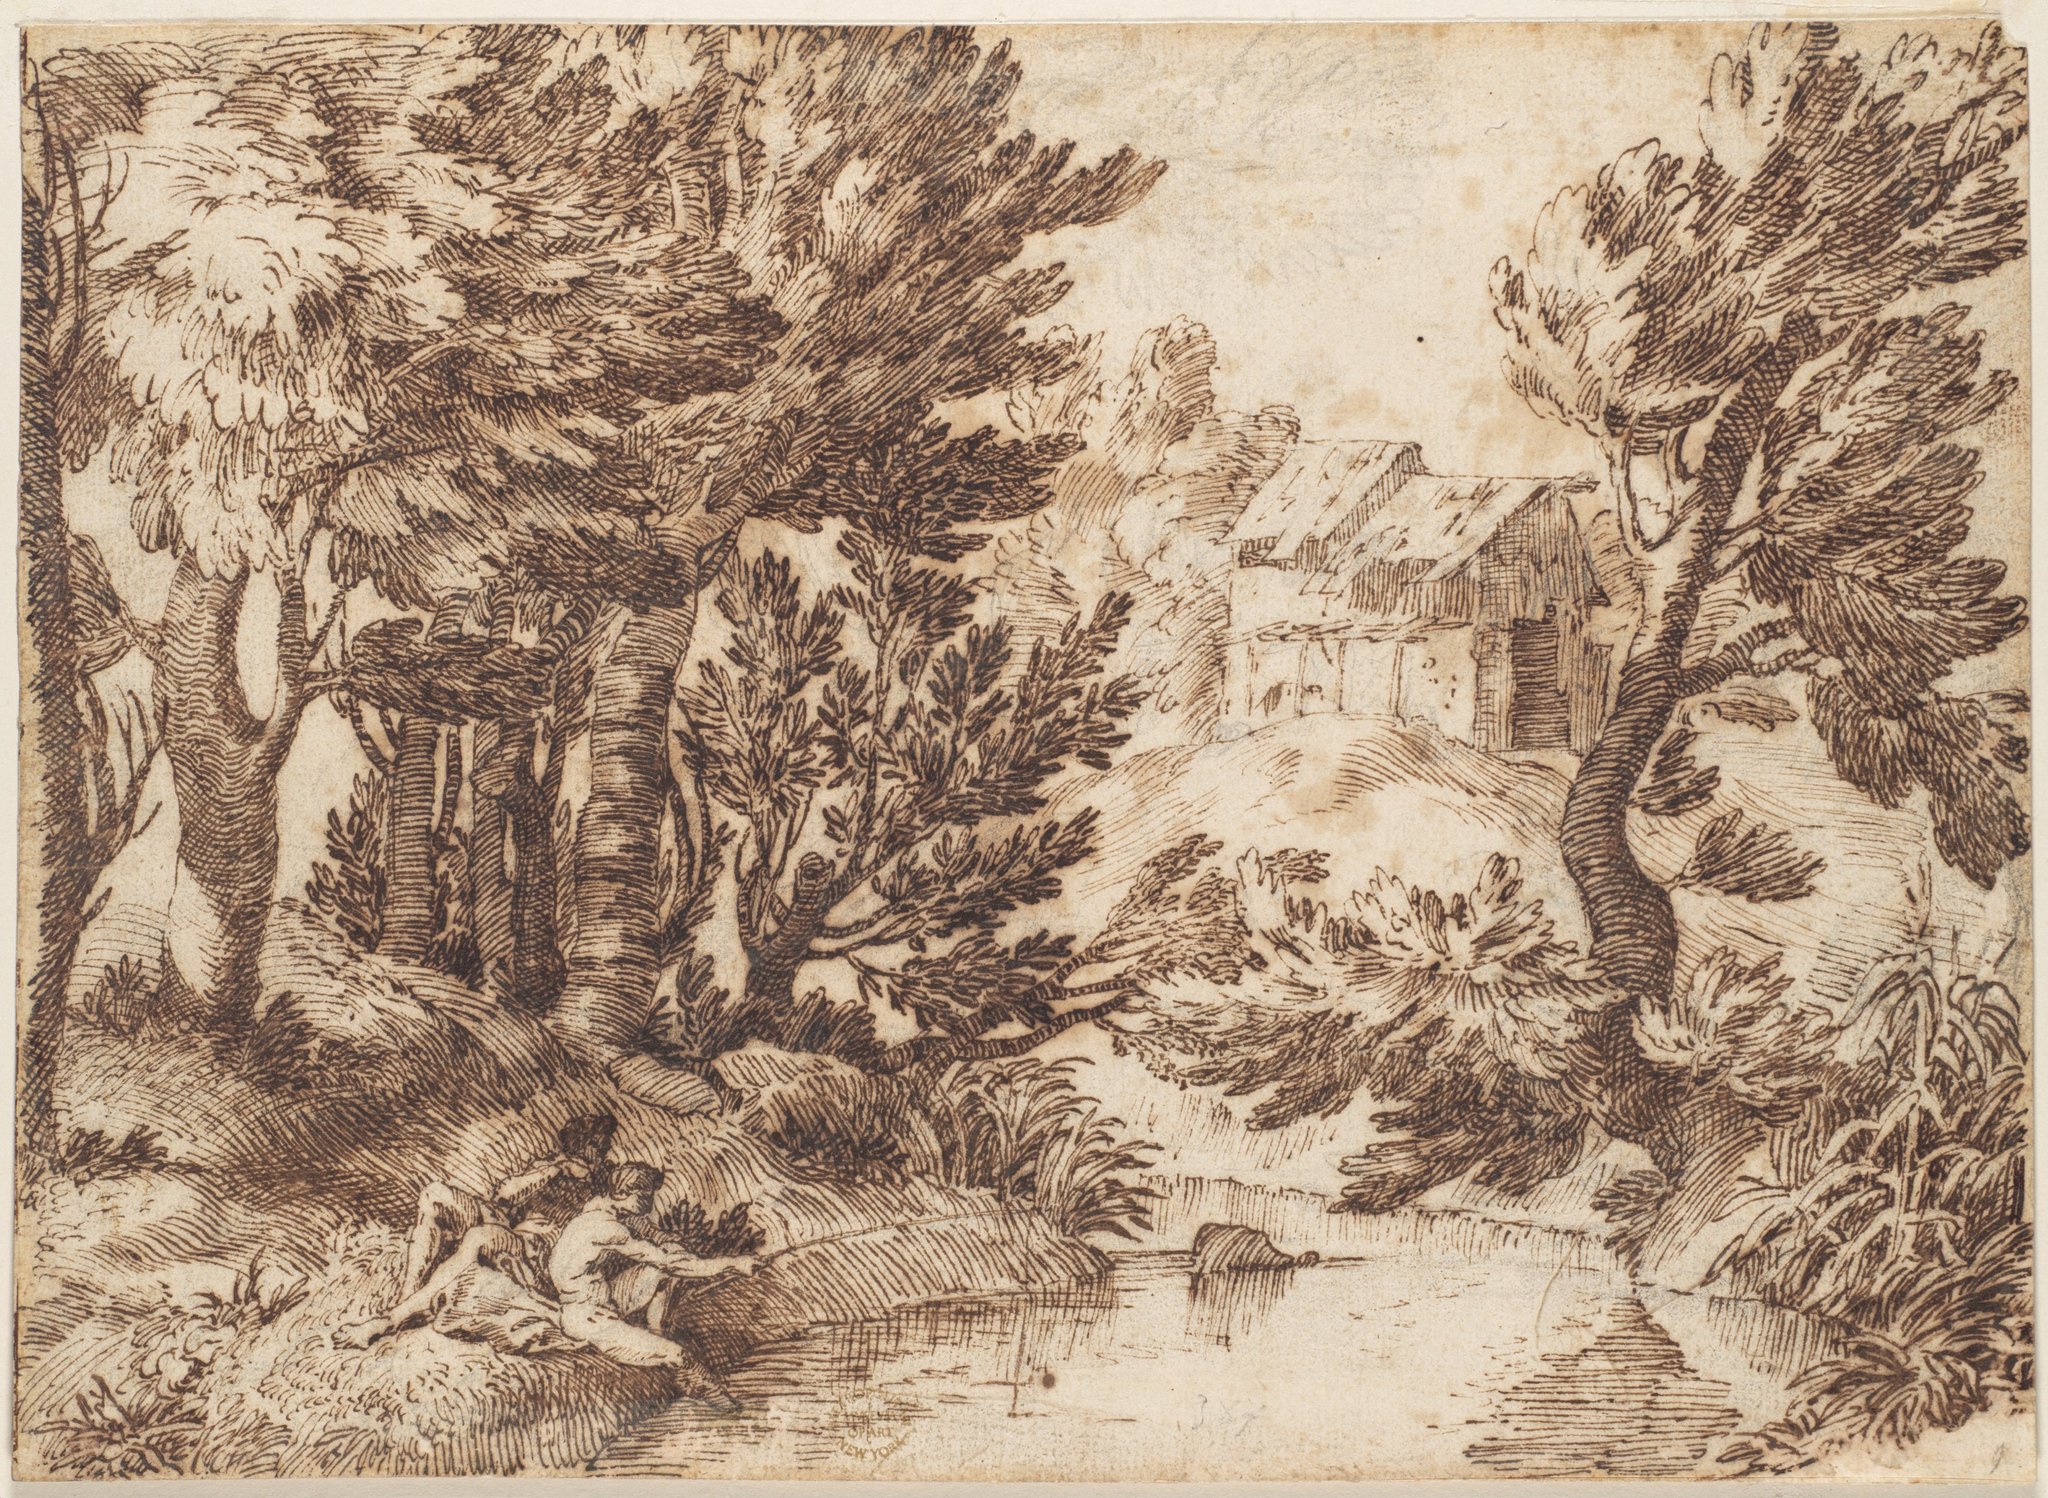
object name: drawing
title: Landscape with Figure Reclining and Figure Fishing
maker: anonymous, italian, roman-bolognese, 17th century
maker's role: artist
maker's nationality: italian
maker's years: 1600-1700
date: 1601-1700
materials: chalk, ink, paper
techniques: pen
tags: houses,men,fishing,landscapes,trees